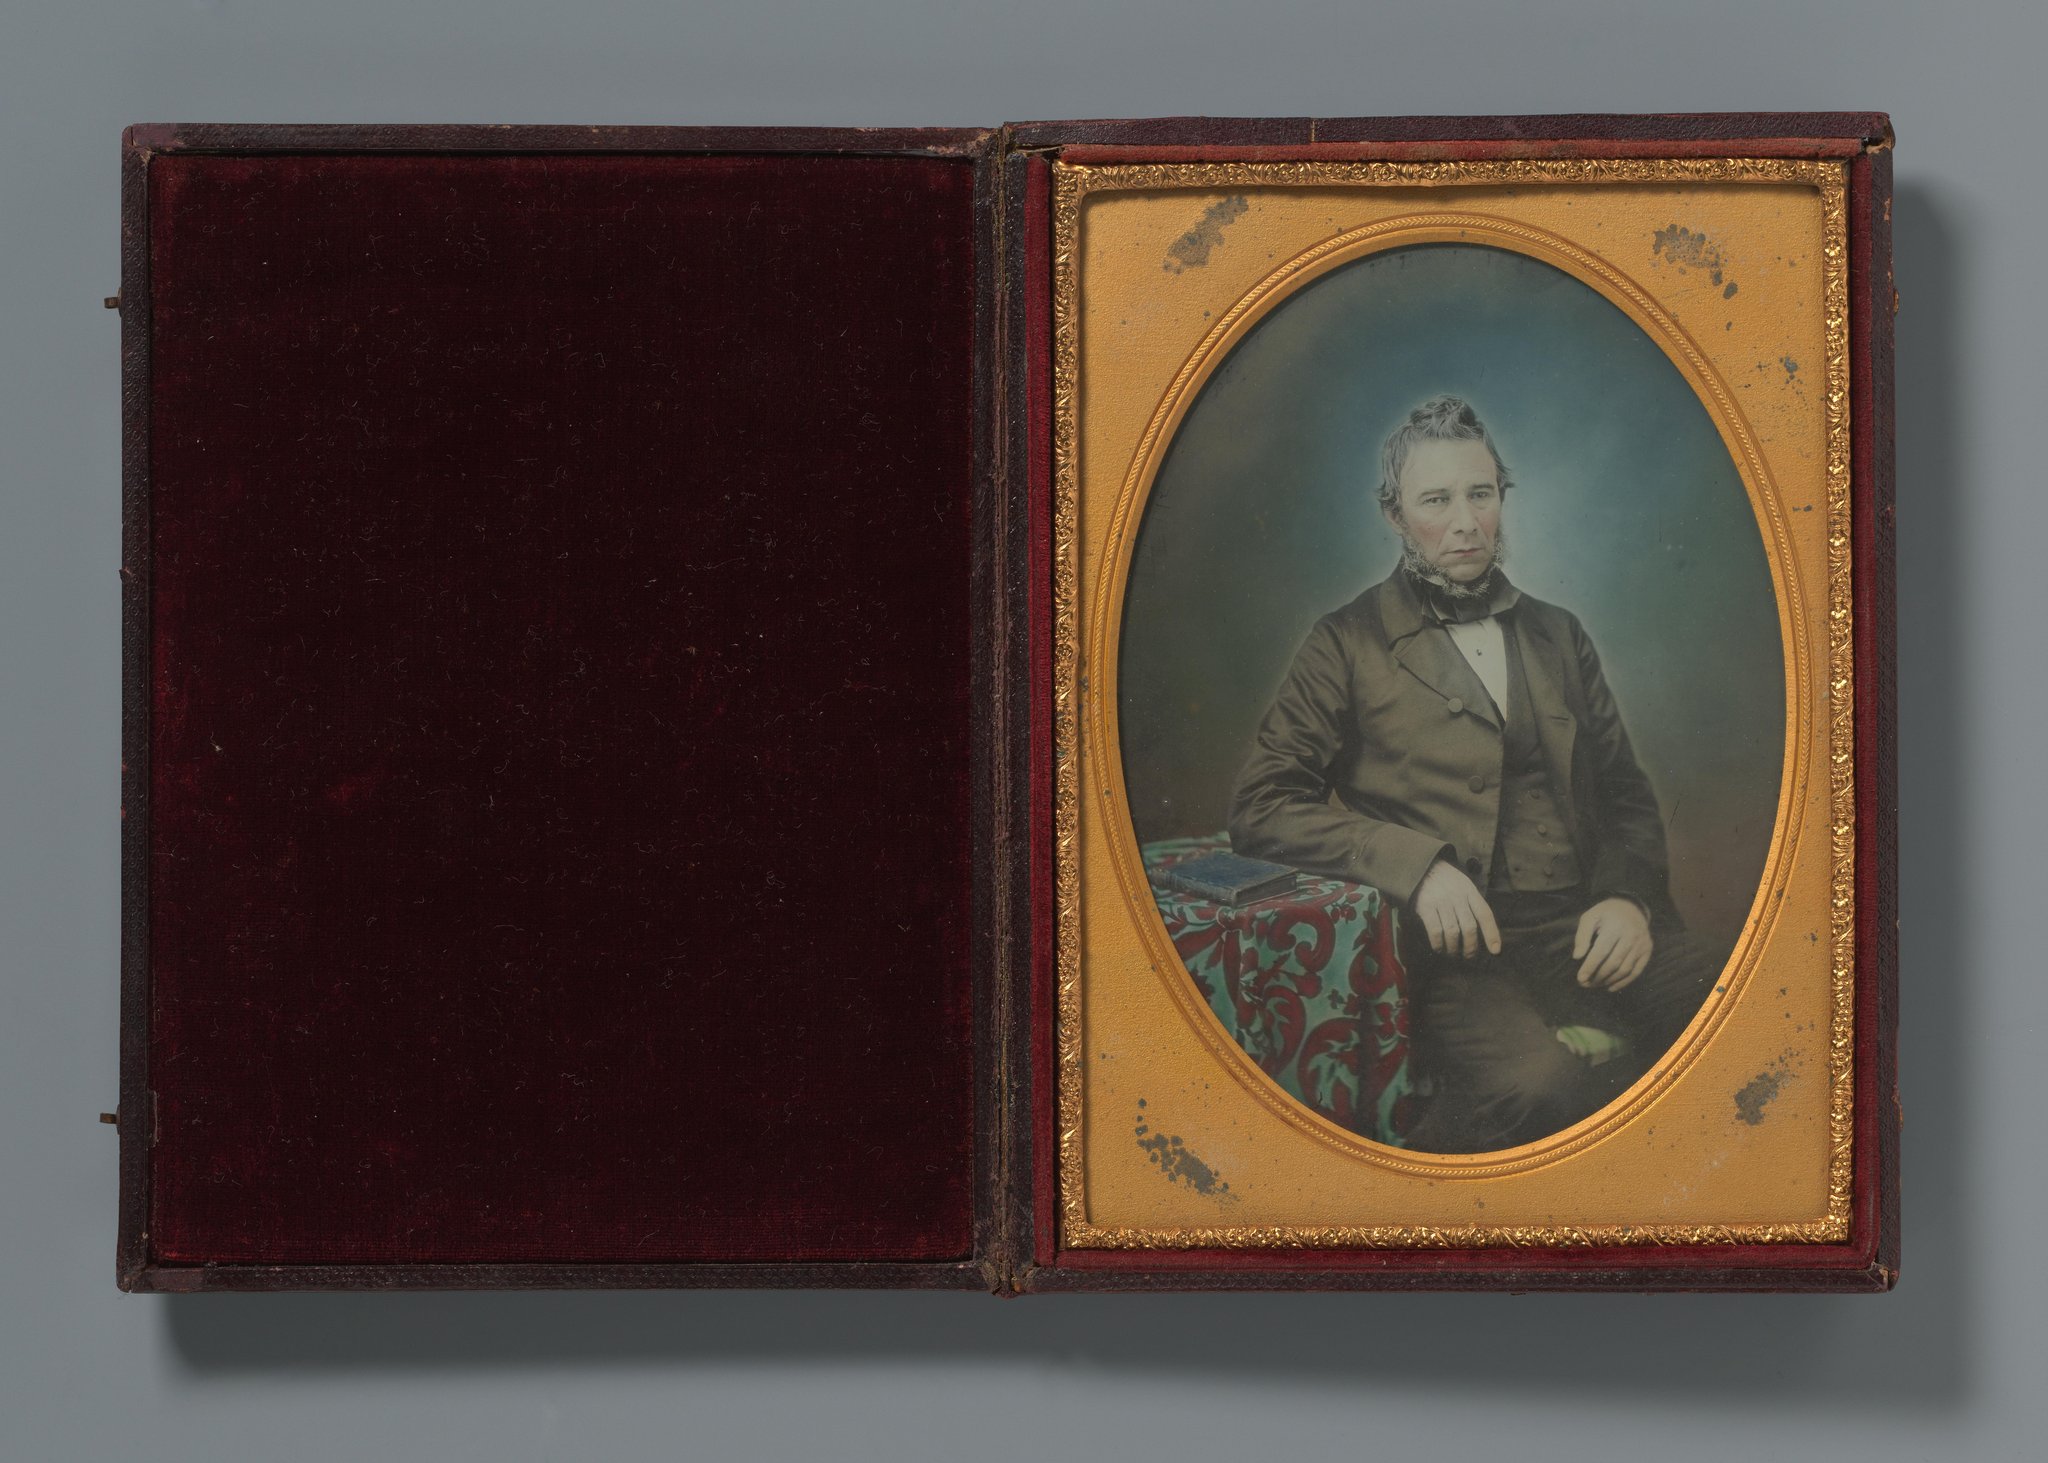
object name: photograph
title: Portret van een onbekende zittende man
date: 1855-1870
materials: glass, leather, metal, velvet, wood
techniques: ambrotype, hand coloring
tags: sitting figure, historical persons